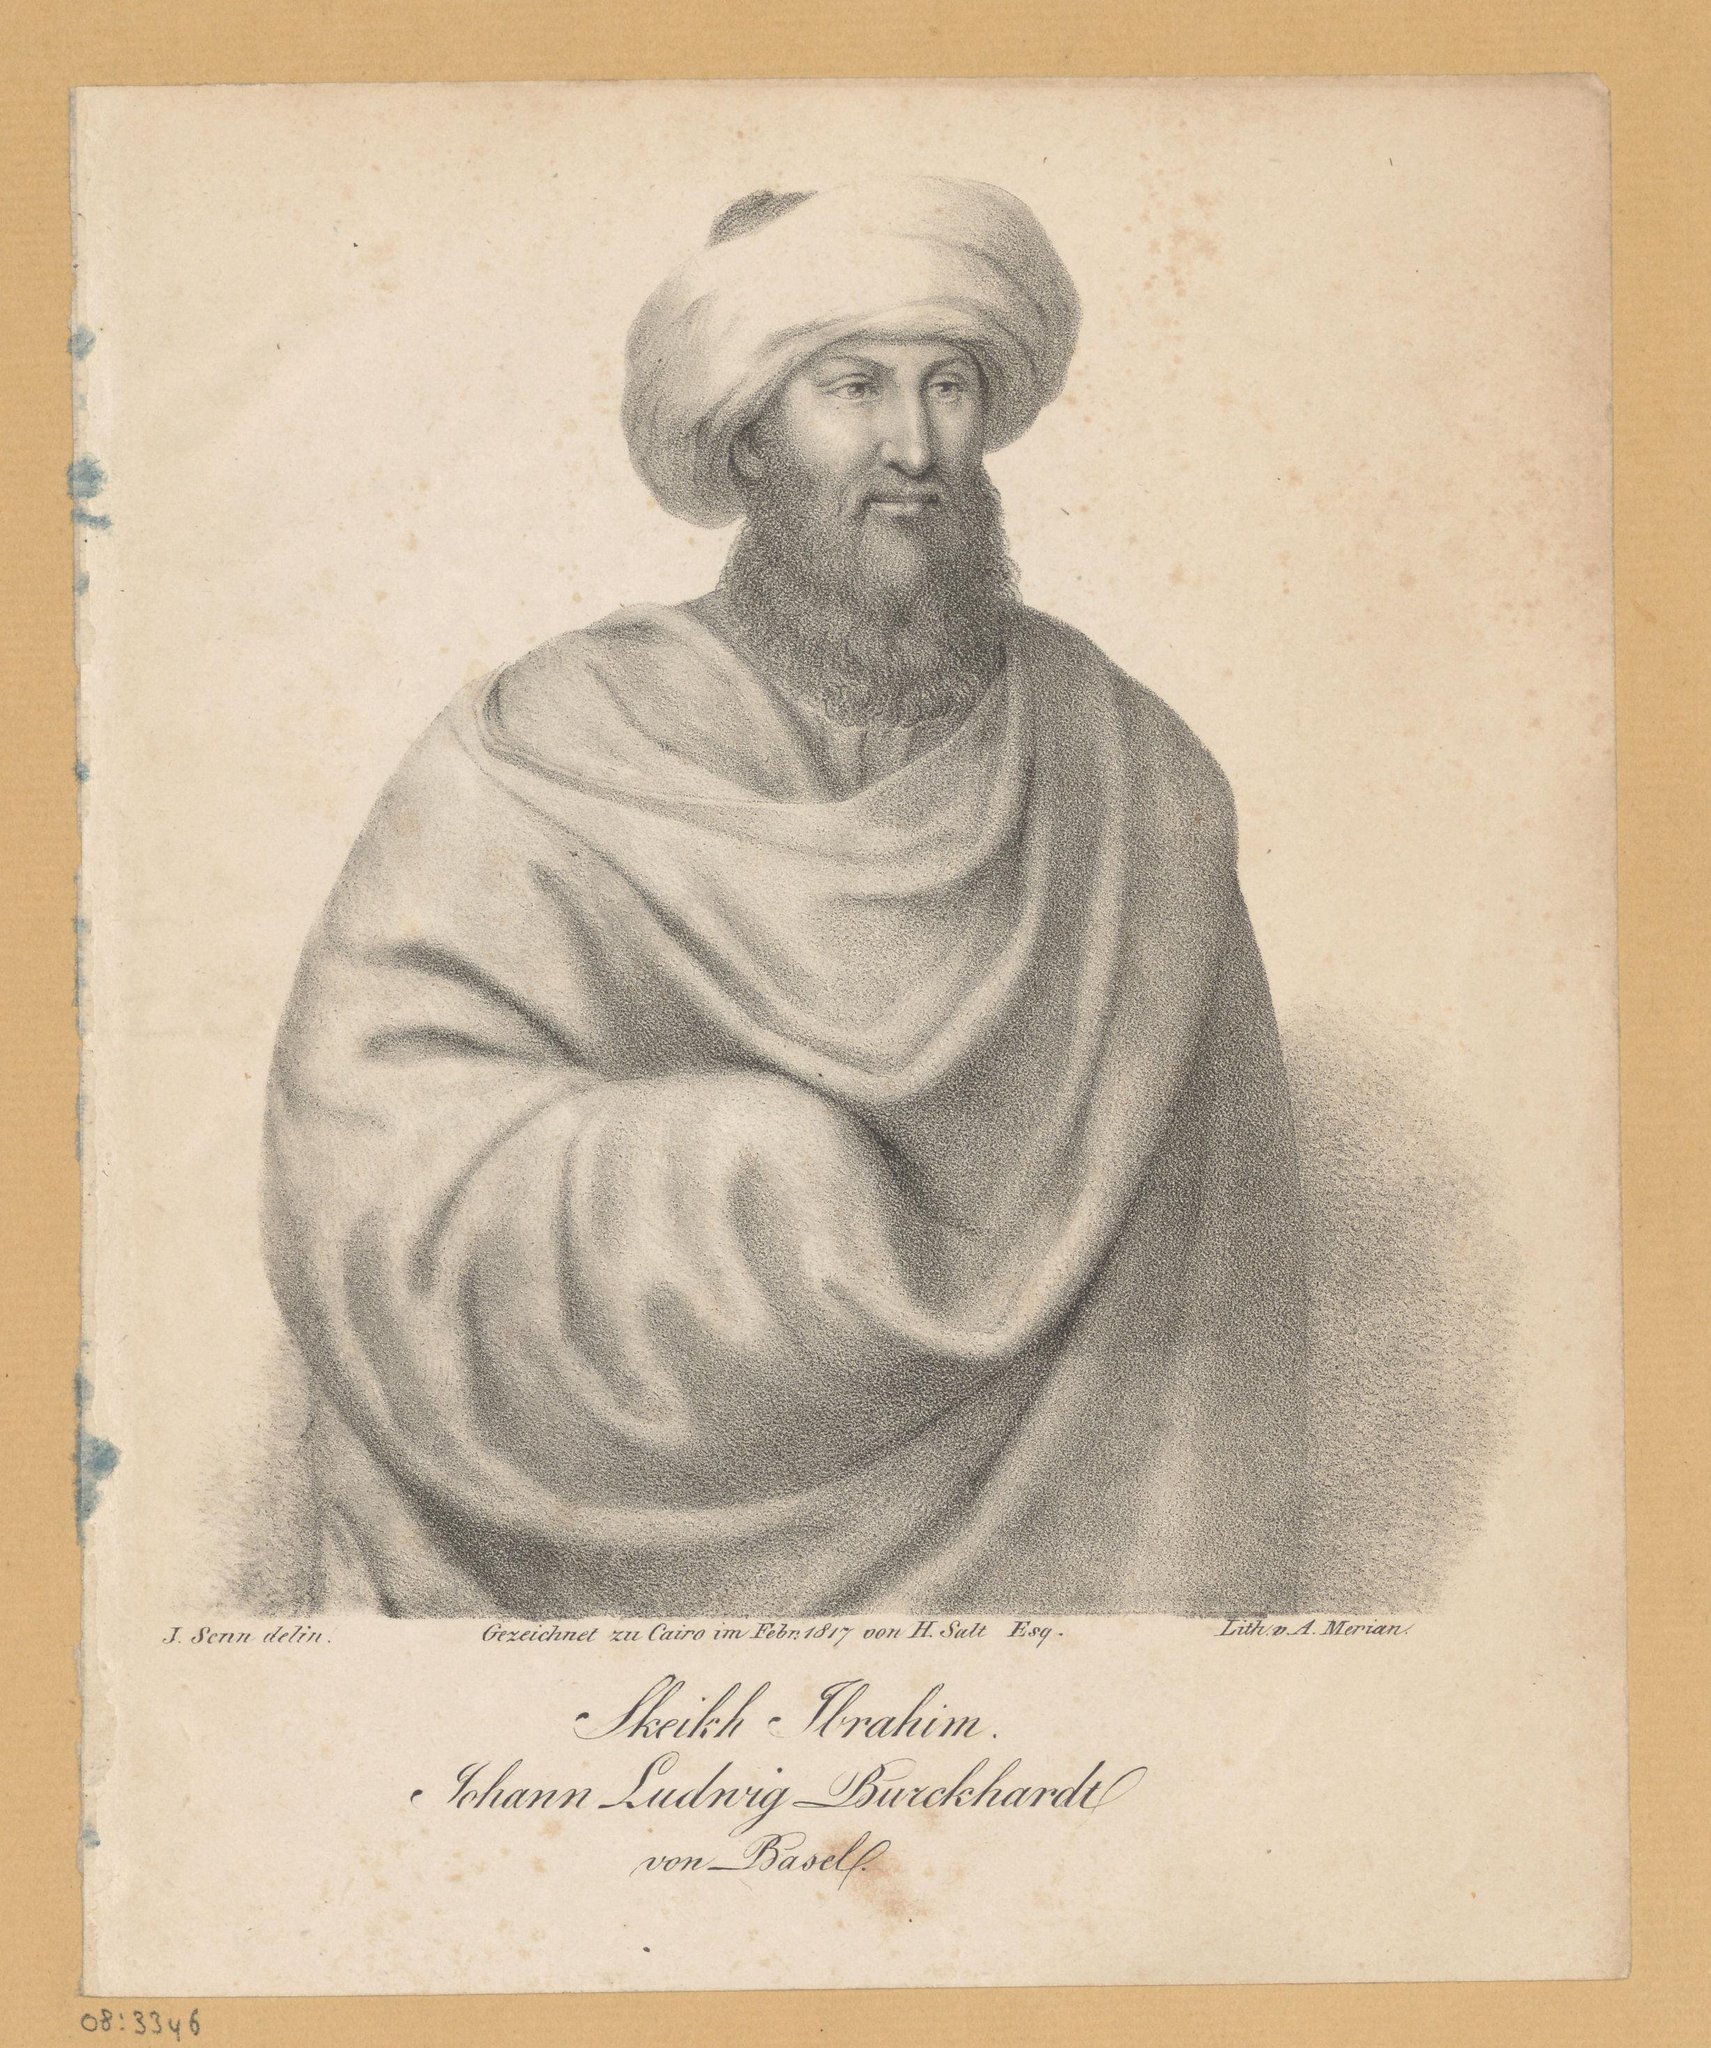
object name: print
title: Portret van Johann Ludwig Burckhardt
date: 1815-1861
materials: paper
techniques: lithograph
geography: cairo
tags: adult man, historical persons, head-gear: turban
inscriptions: collector's mark: Lugt 2228